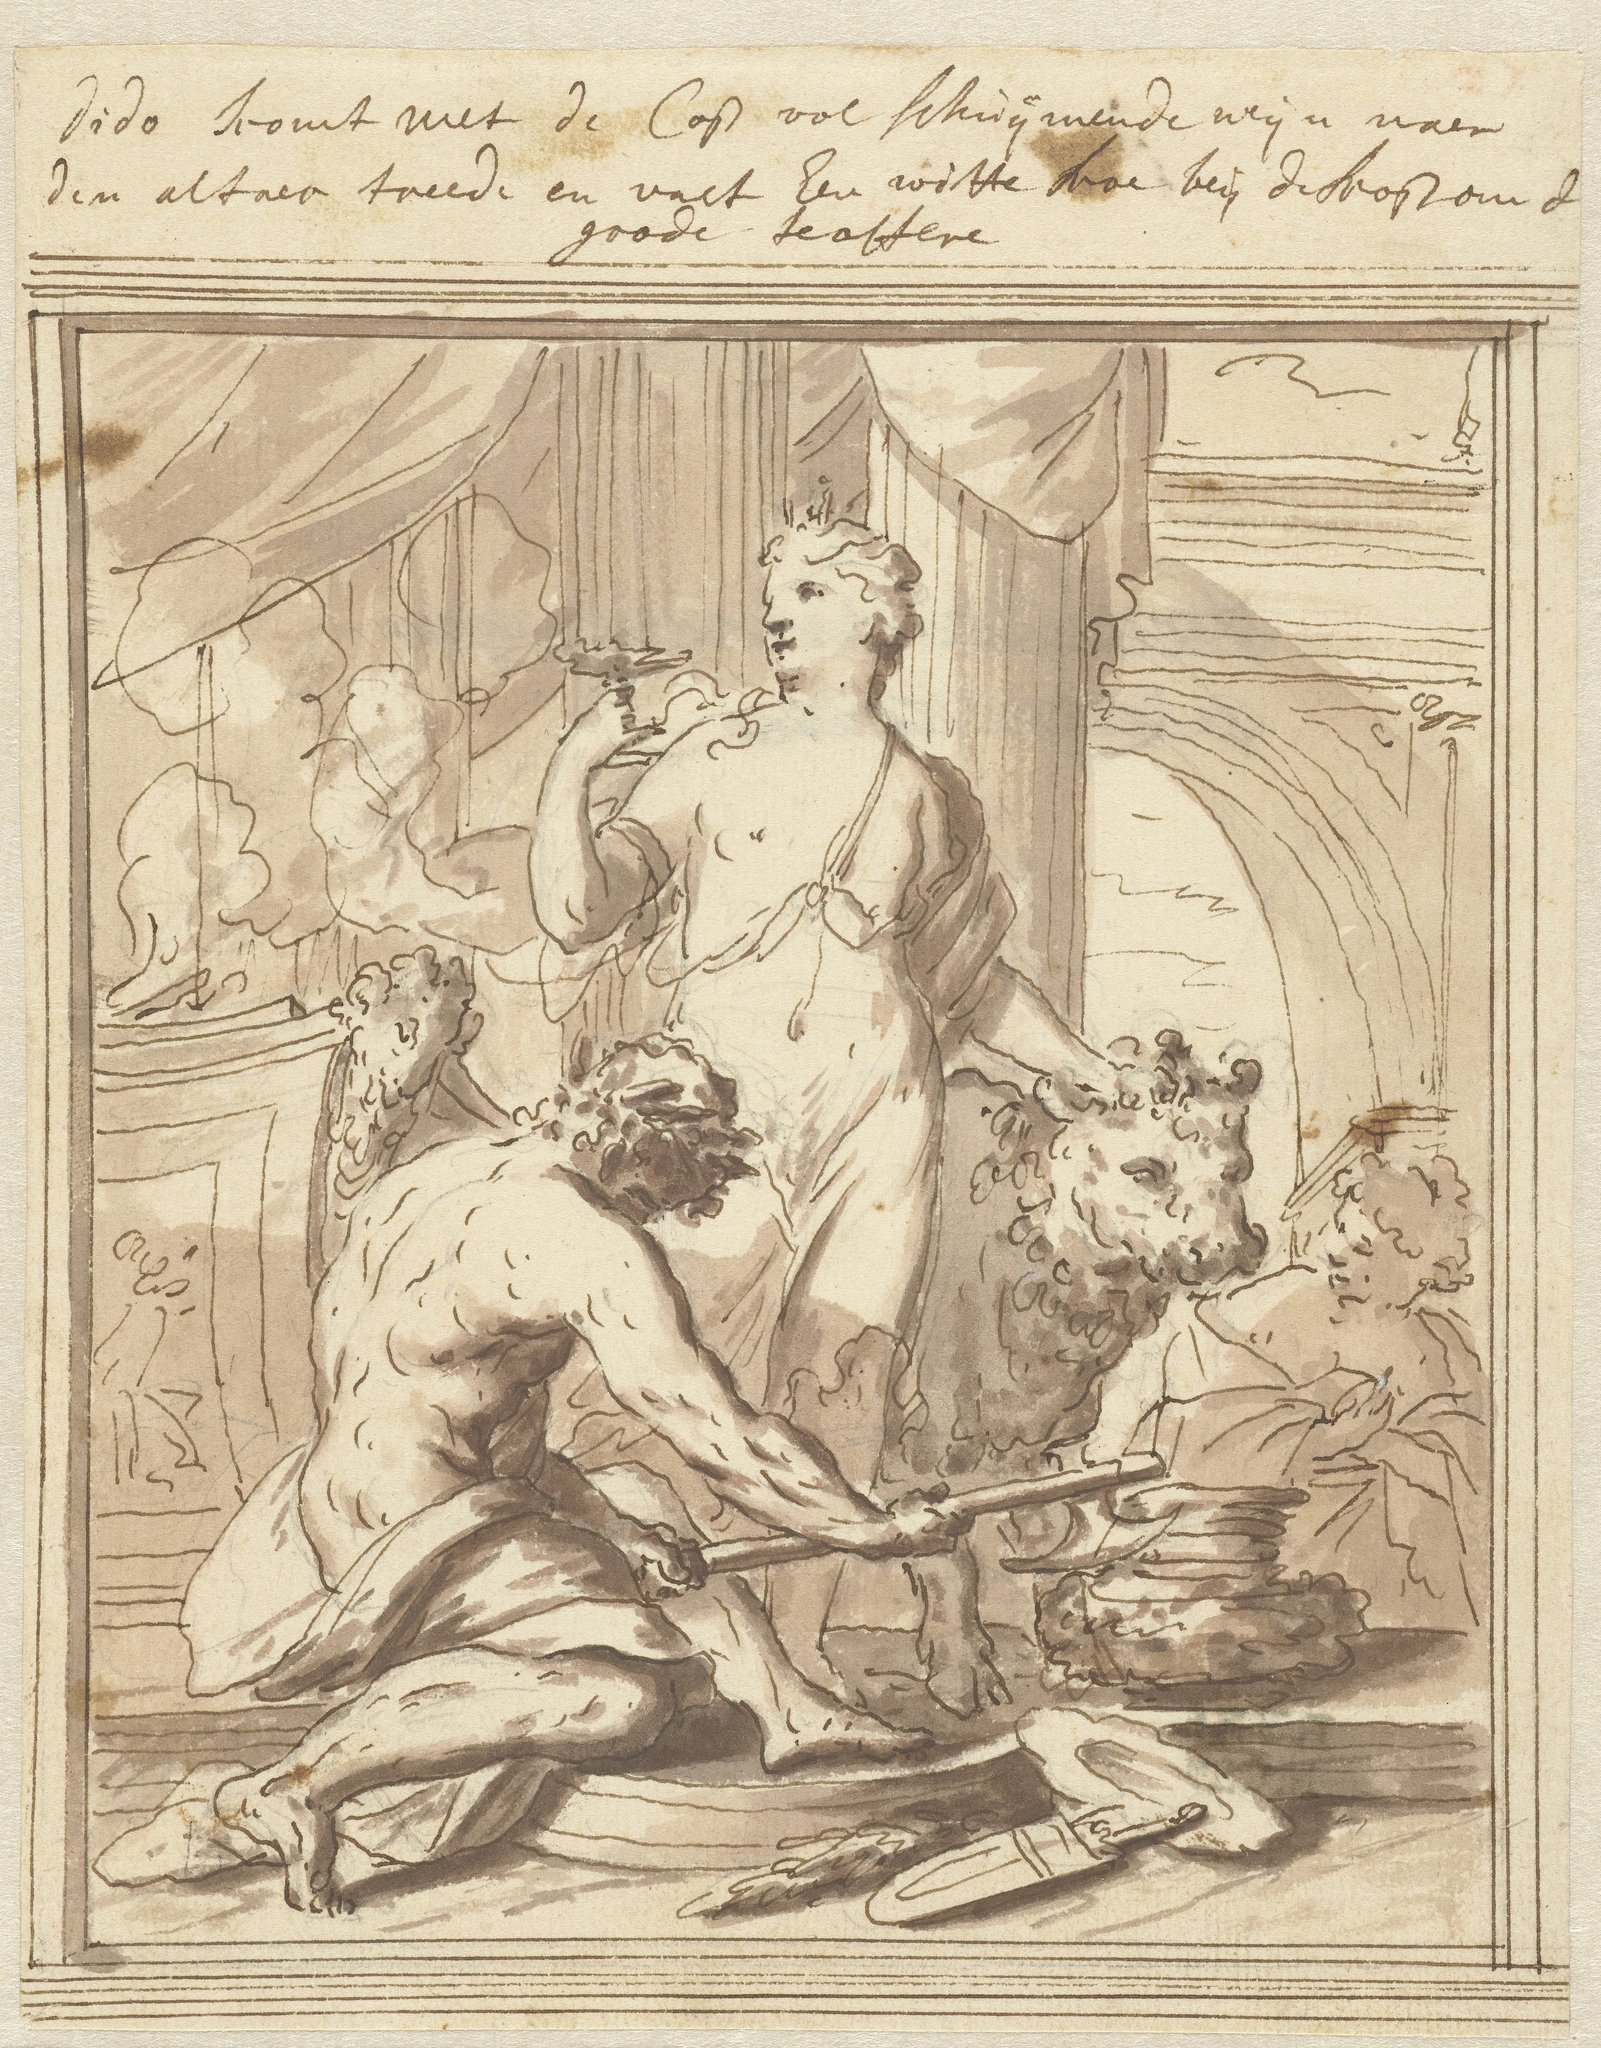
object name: drawing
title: Ontwerpen voor schilderijen met episodes uit De Aeneas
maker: mattheus terwesten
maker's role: draughtsman, painter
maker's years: 1670-1757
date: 1600-1604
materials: graphite, ink, paper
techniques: brush, pen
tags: sacrifice ~ non-christian religions, non-aggressive, friendly or neutral activities and relationships of dido, scenes from the aeneid that cannot be located in the chronological sequence of the story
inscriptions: : ‘dido komt met Cop vol schuijmende wijn naer den altaer treede en vaet een witte koe bij de kop om de goode te offere’